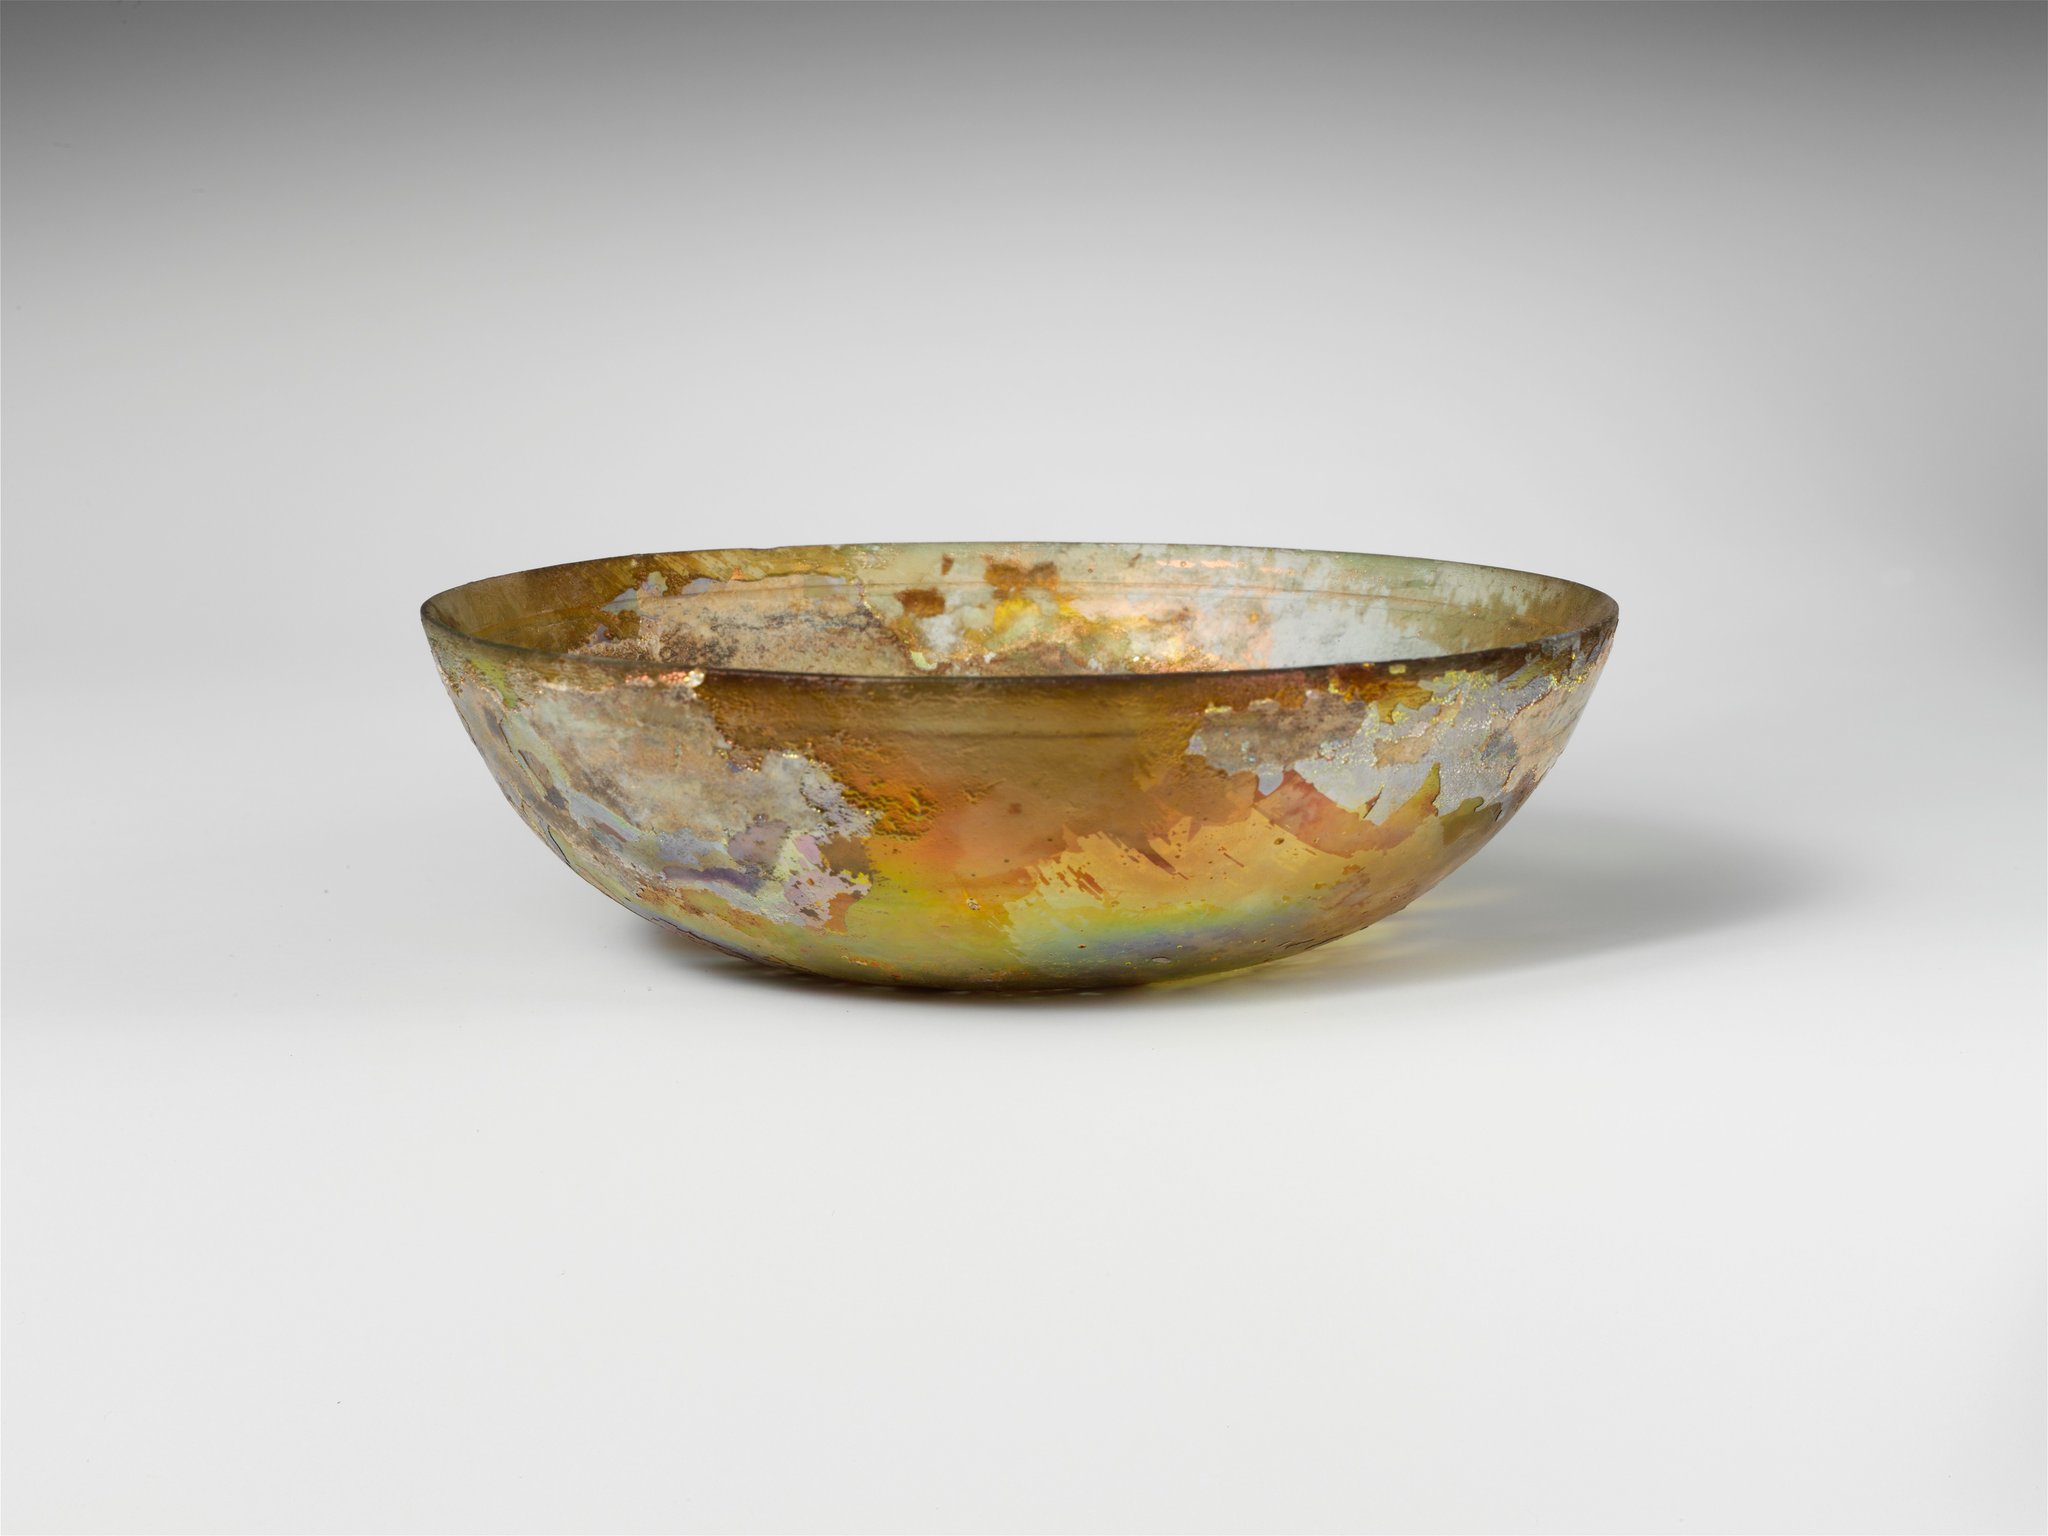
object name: bowl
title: Glass bowl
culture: roman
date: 34 BCE-33 CE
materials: glass